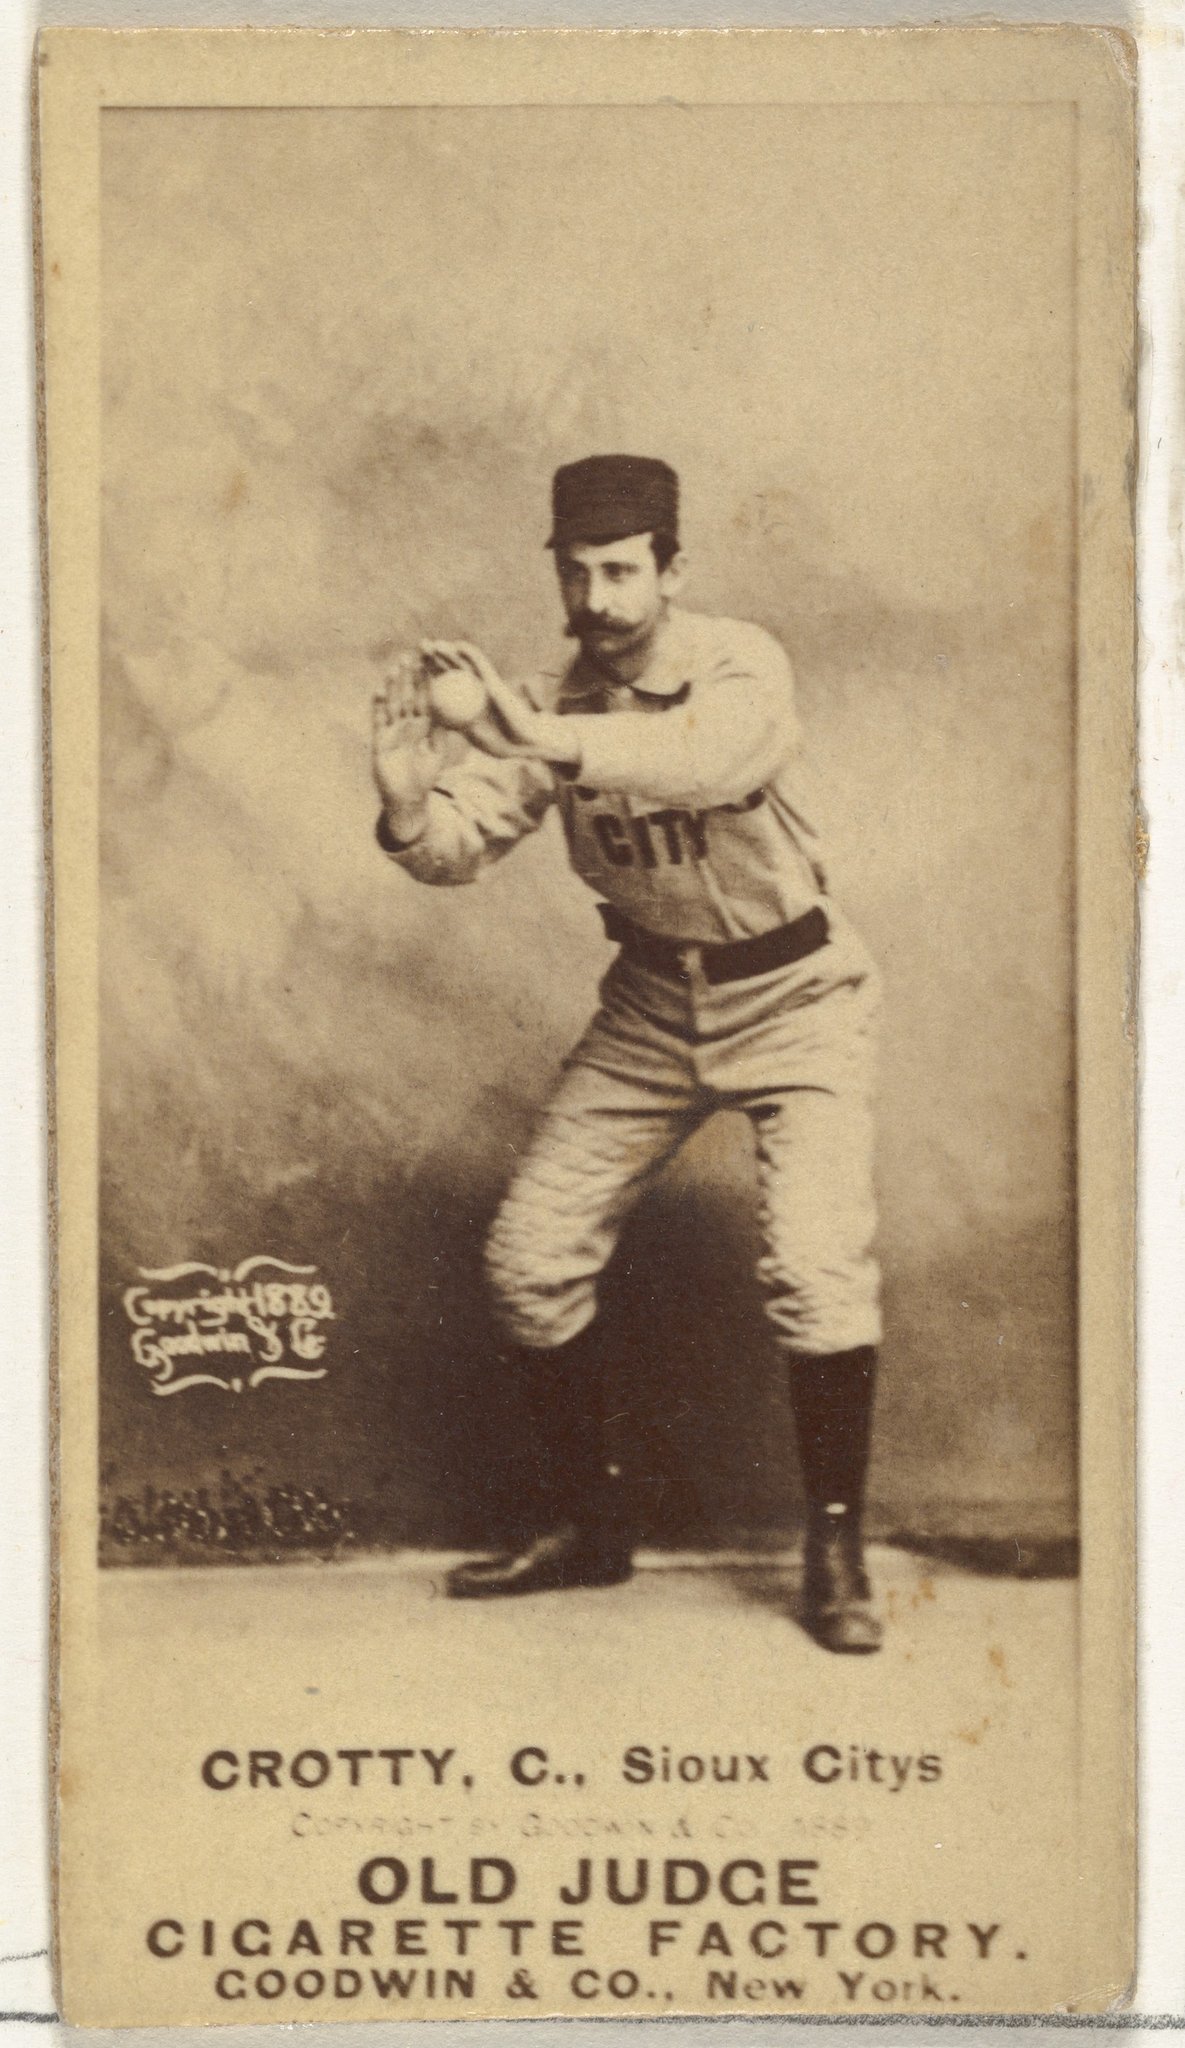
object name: baseball card, photograph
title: Joseph P. "Joe" Crotty, Catcher, Sioux City Corn Huskers, from the Old Judge series (N172) for Old Judge Cigarettes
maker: goodwin & company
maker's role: publisher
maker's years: 1850-1950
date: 1889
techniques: albumen silver print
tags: men,portraits,baseball,athletes